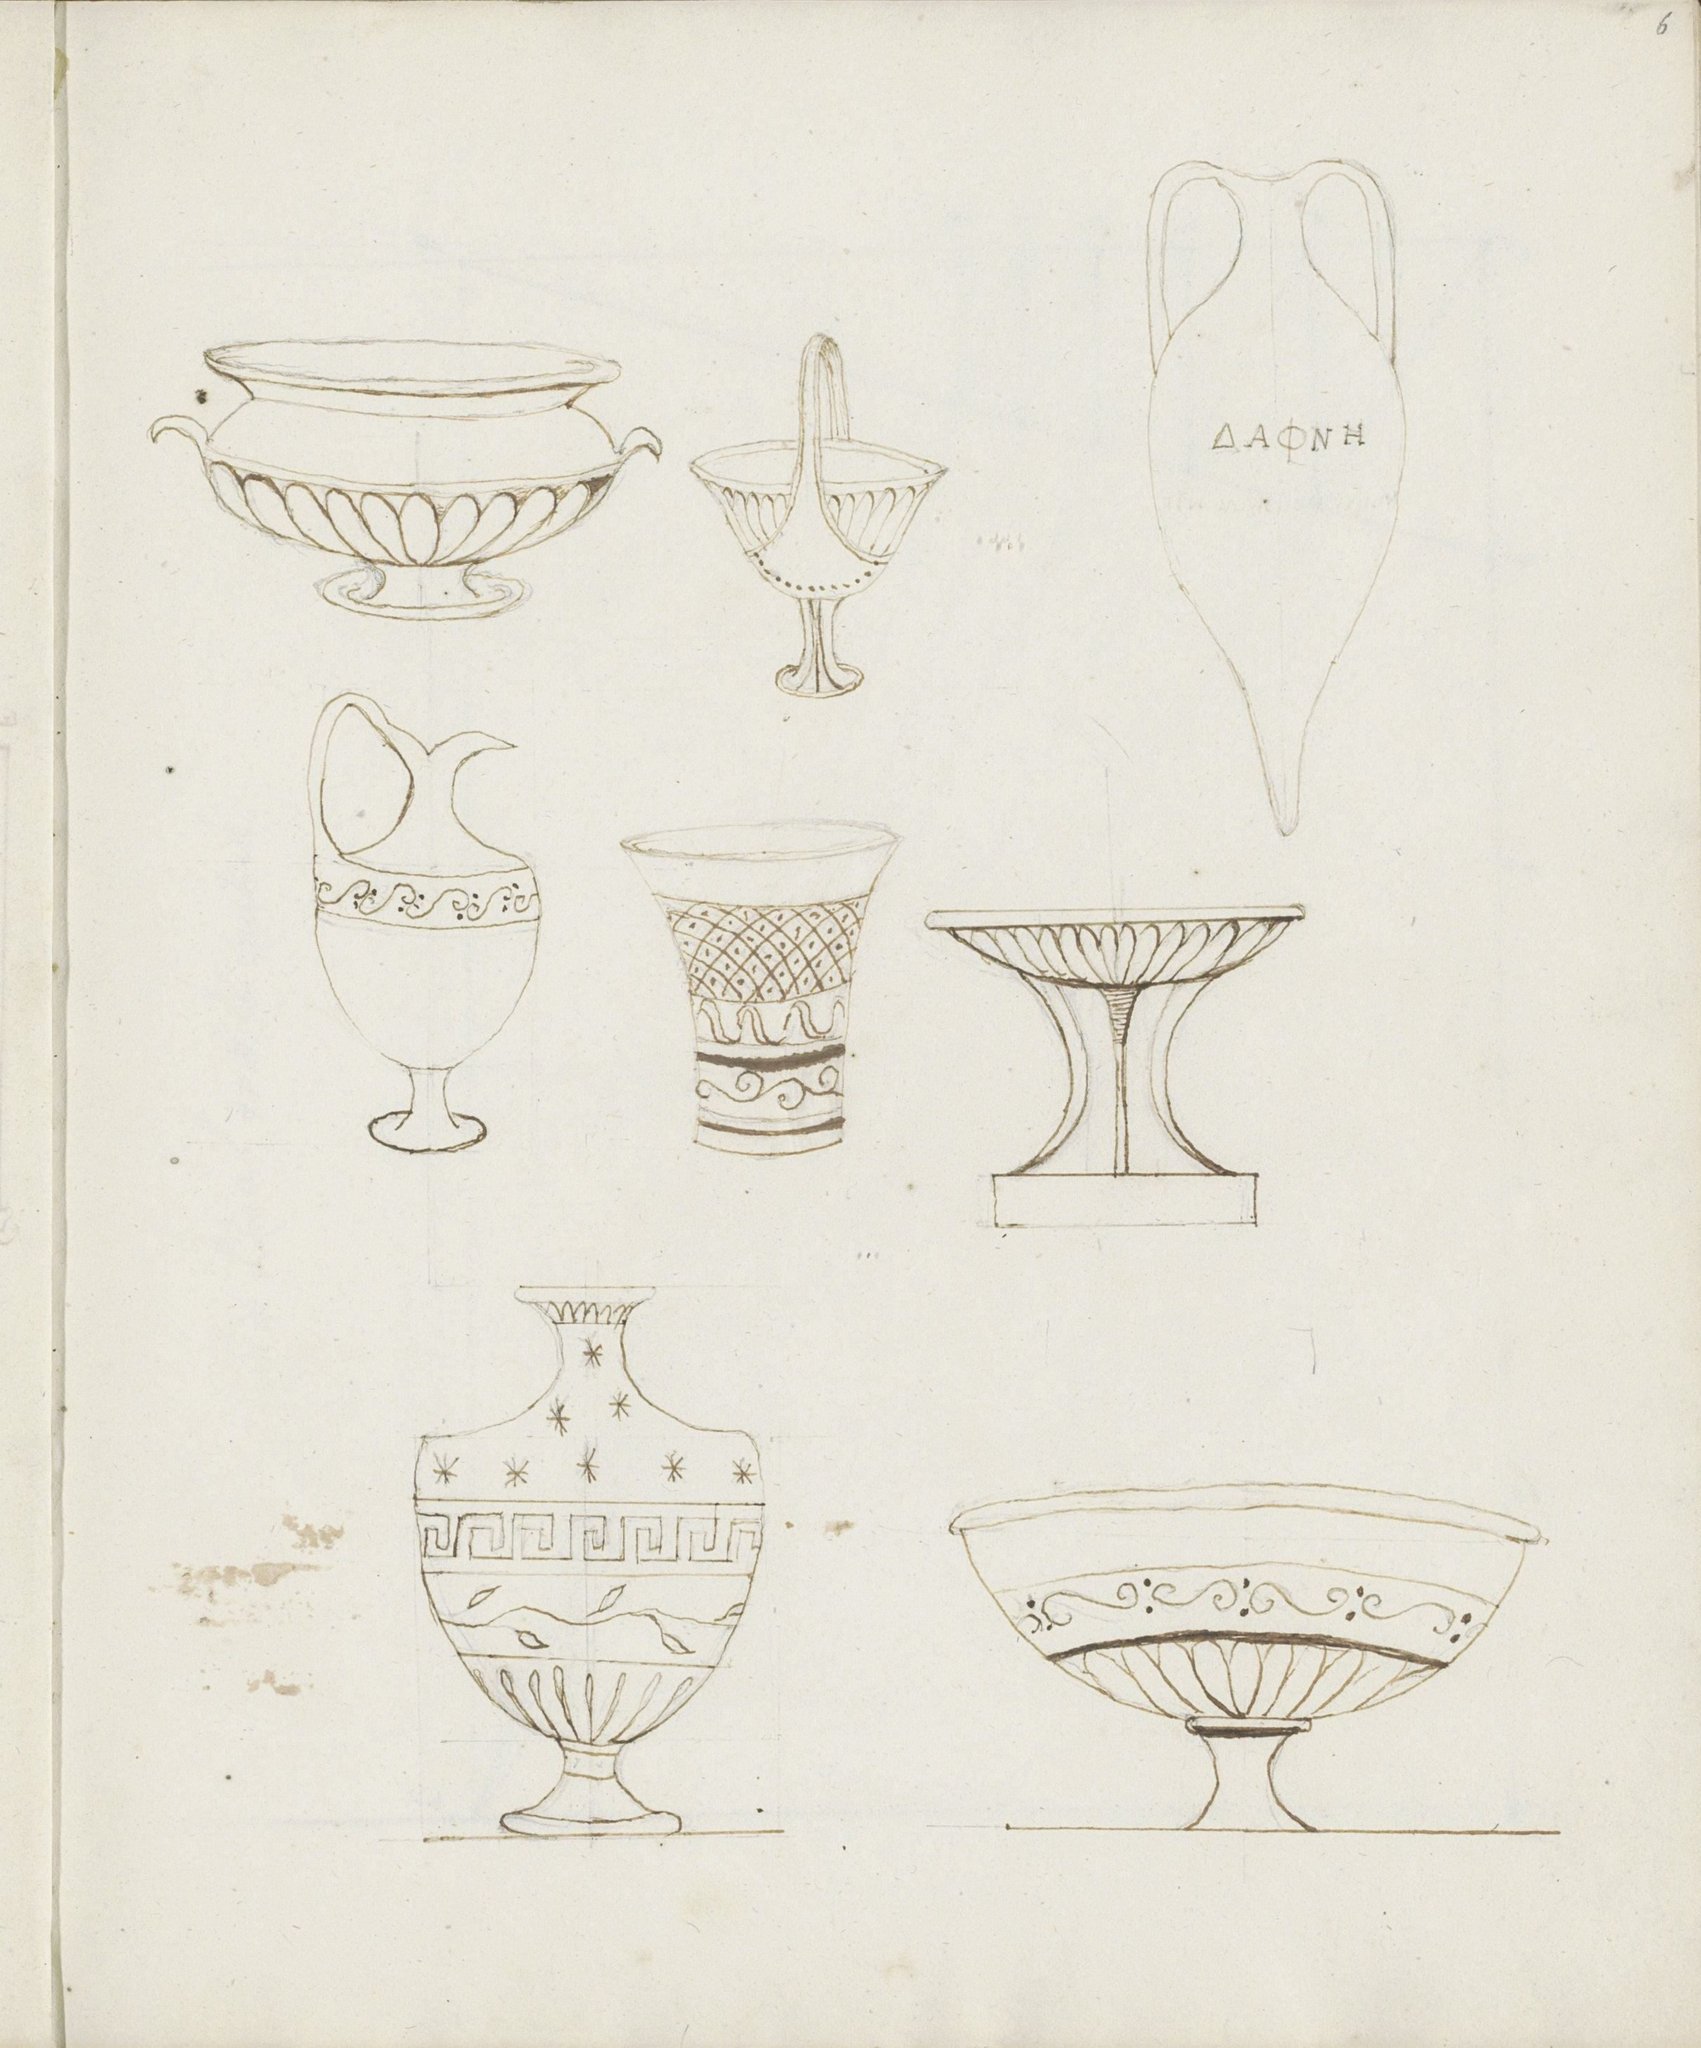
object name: sketchbook leaf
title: Griekse vazen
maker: jonkvrouw catharina kemper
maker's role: draughtsman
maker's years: 1801-1871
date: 1813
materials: ink, paper, pencil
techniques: pen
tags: container of stone: stone vase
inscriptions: annotation: ‘DAPHNE’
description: Blad 6 recto uit een schetsboek met 91 bladen.